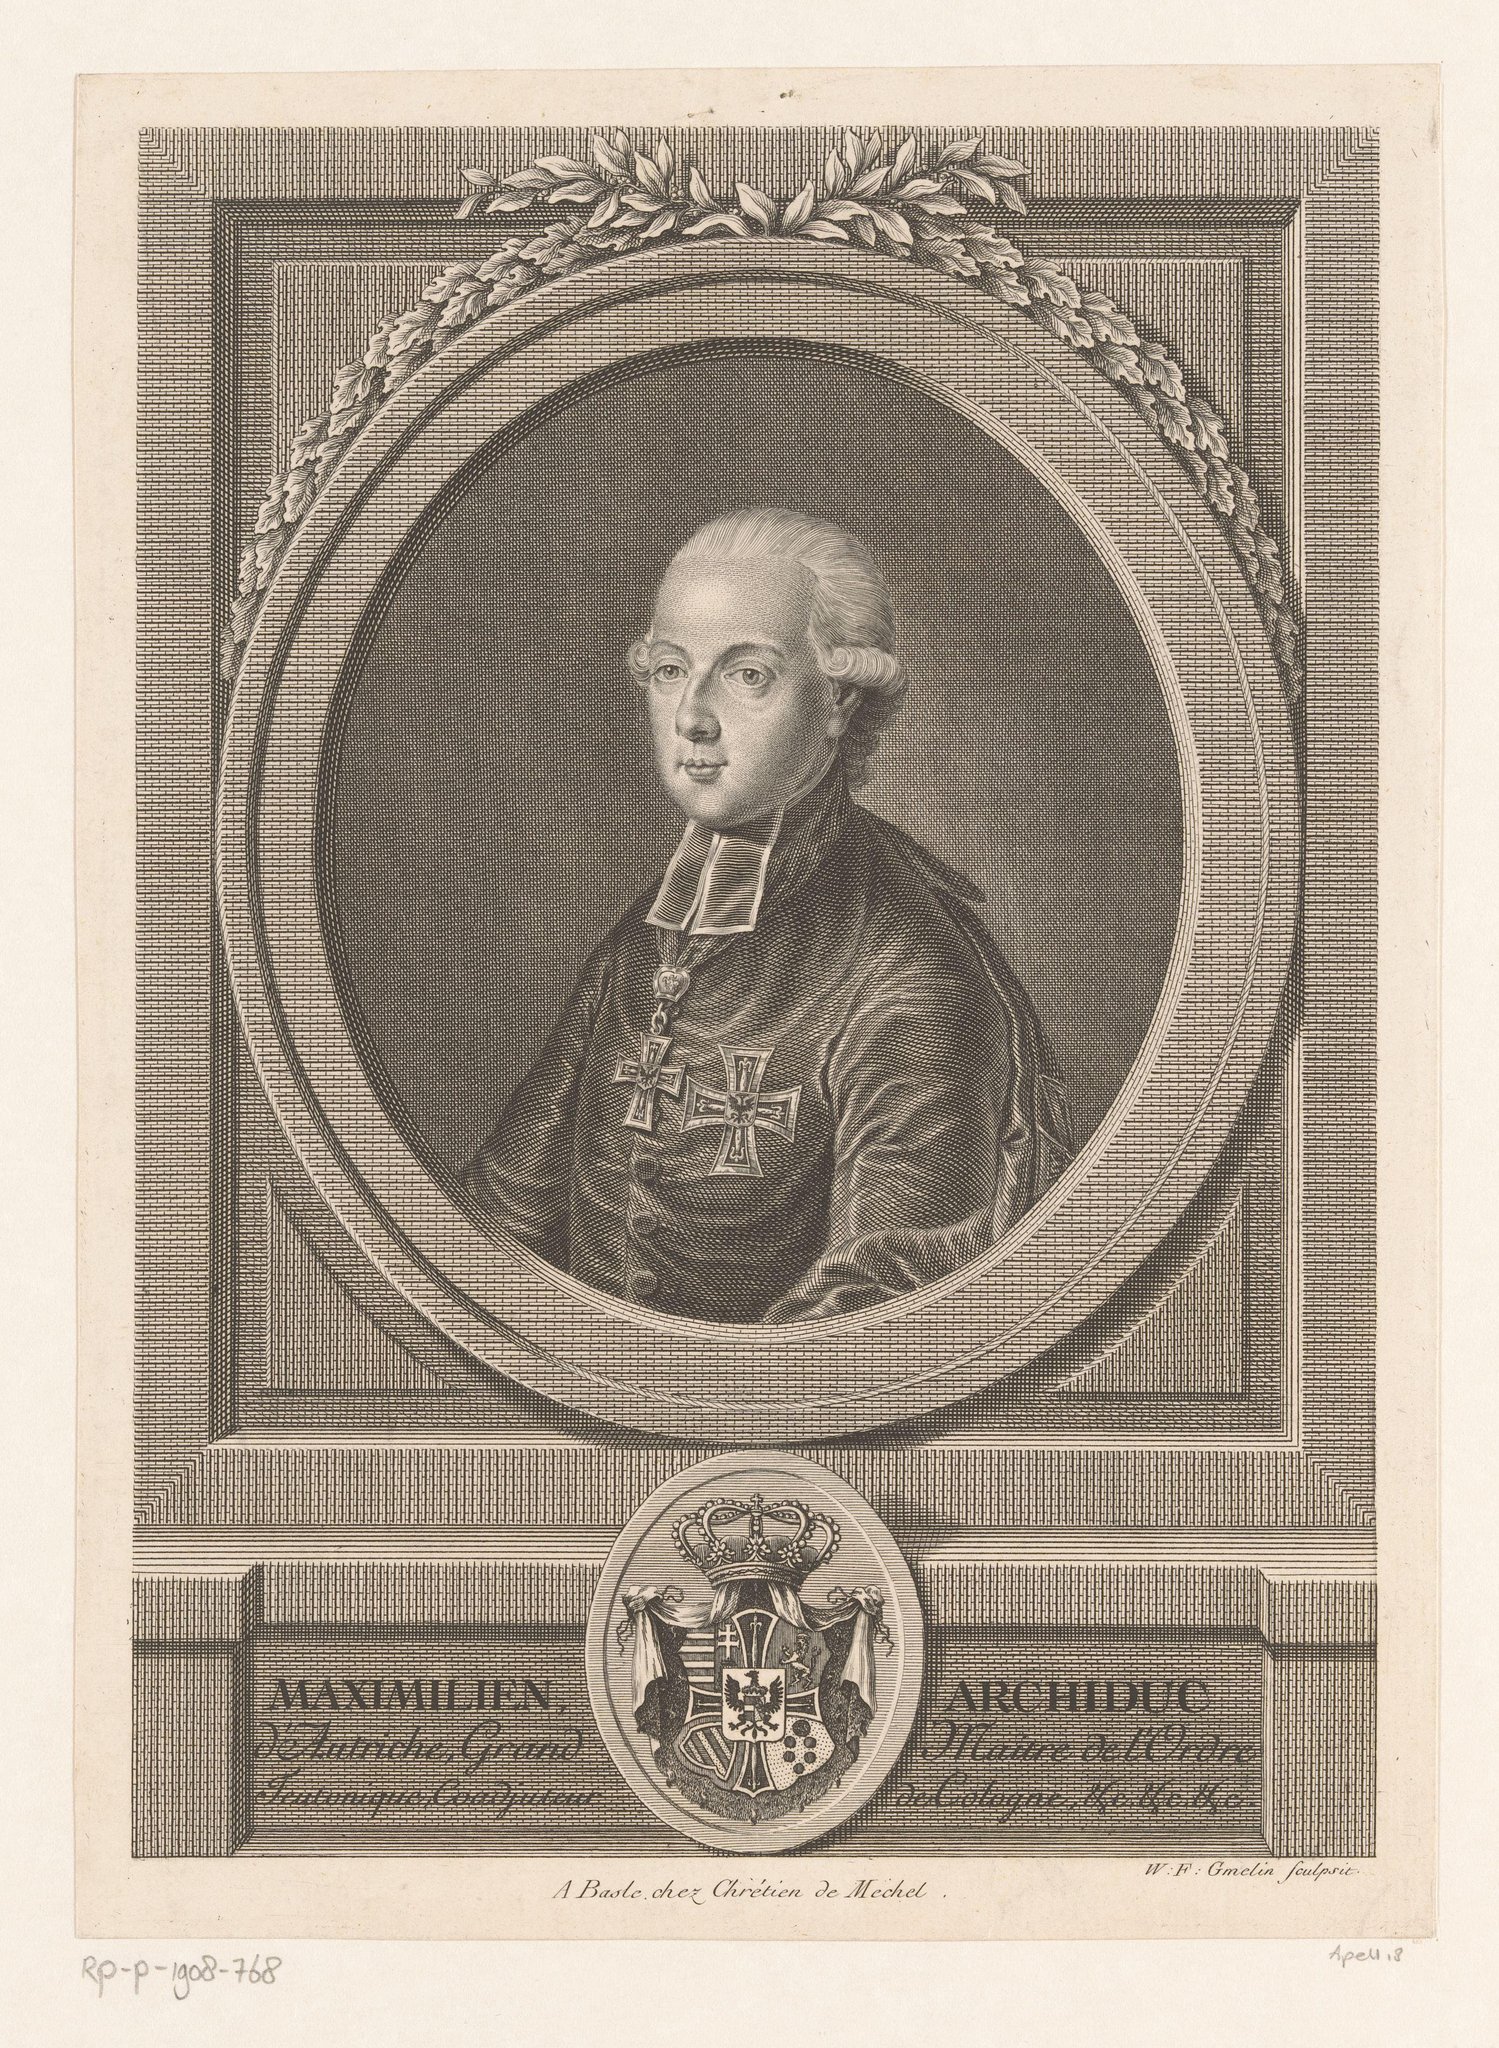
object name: print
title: Portret van Maximilian Franz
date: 1760-1801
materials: paper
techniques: engraving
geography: basel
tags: historical persons, ornament ~ festoon, garland, armorial bearing, heraldry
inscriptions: collector's mark: Lugt 2228